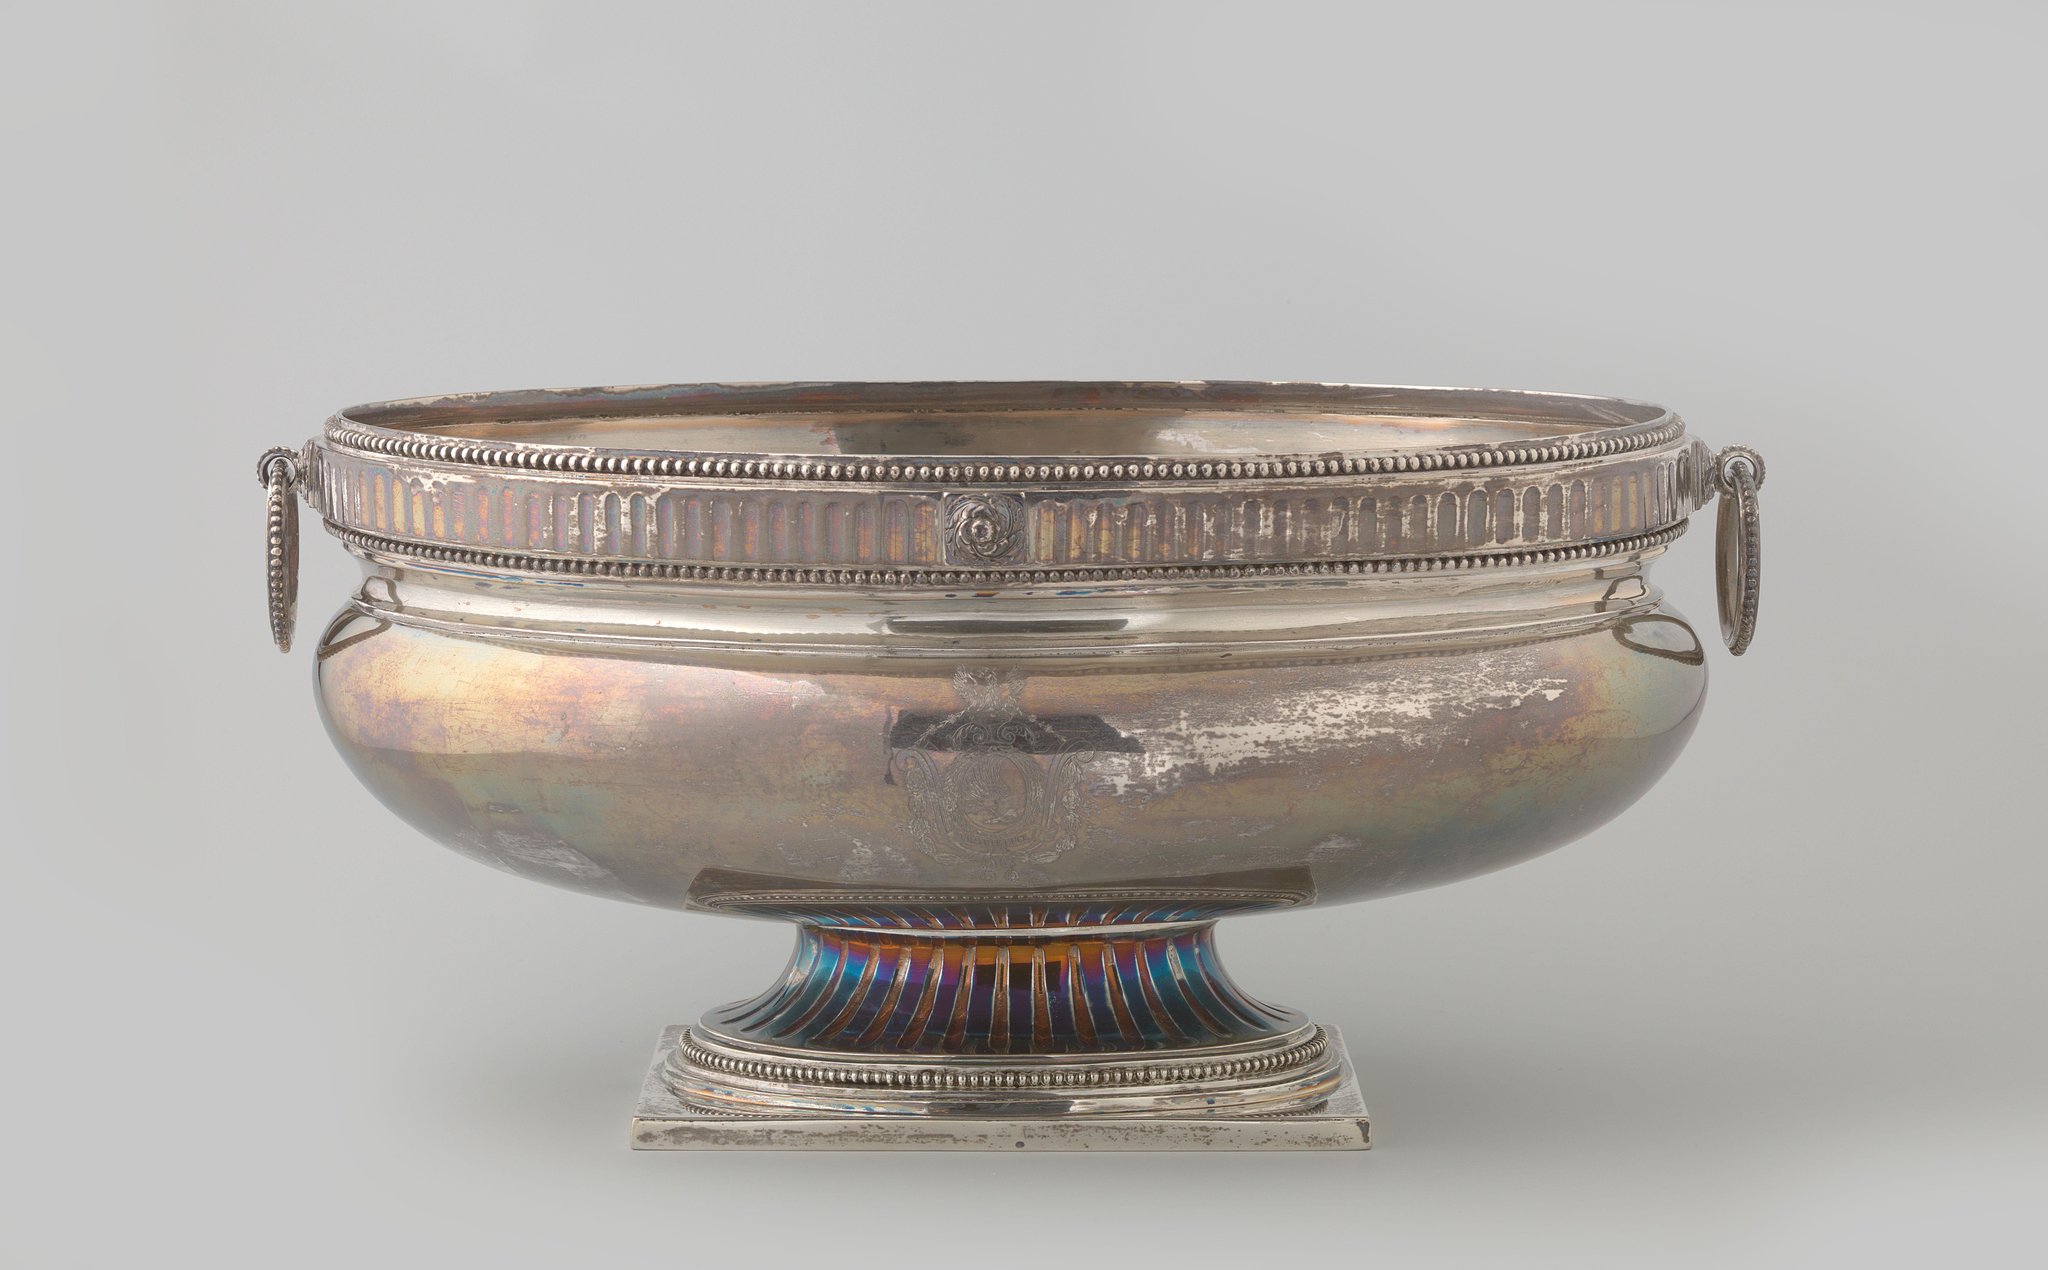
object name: wine cooler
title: Koelvat met de familiewapens Van Loon en Rendorp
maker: anton hinrich pape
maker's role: silversmith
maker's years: 1746-1816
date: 1783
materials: silver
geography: amsterdam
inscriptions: date letter: ‘Y’, duty mark, alloy mark, town mark, maker's mark, : ‘L’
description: Wine cooler with the arms of the Van Loon and Rendorp families. Silver. Amsterdam, 1783, by Anton Hendrik Paap.